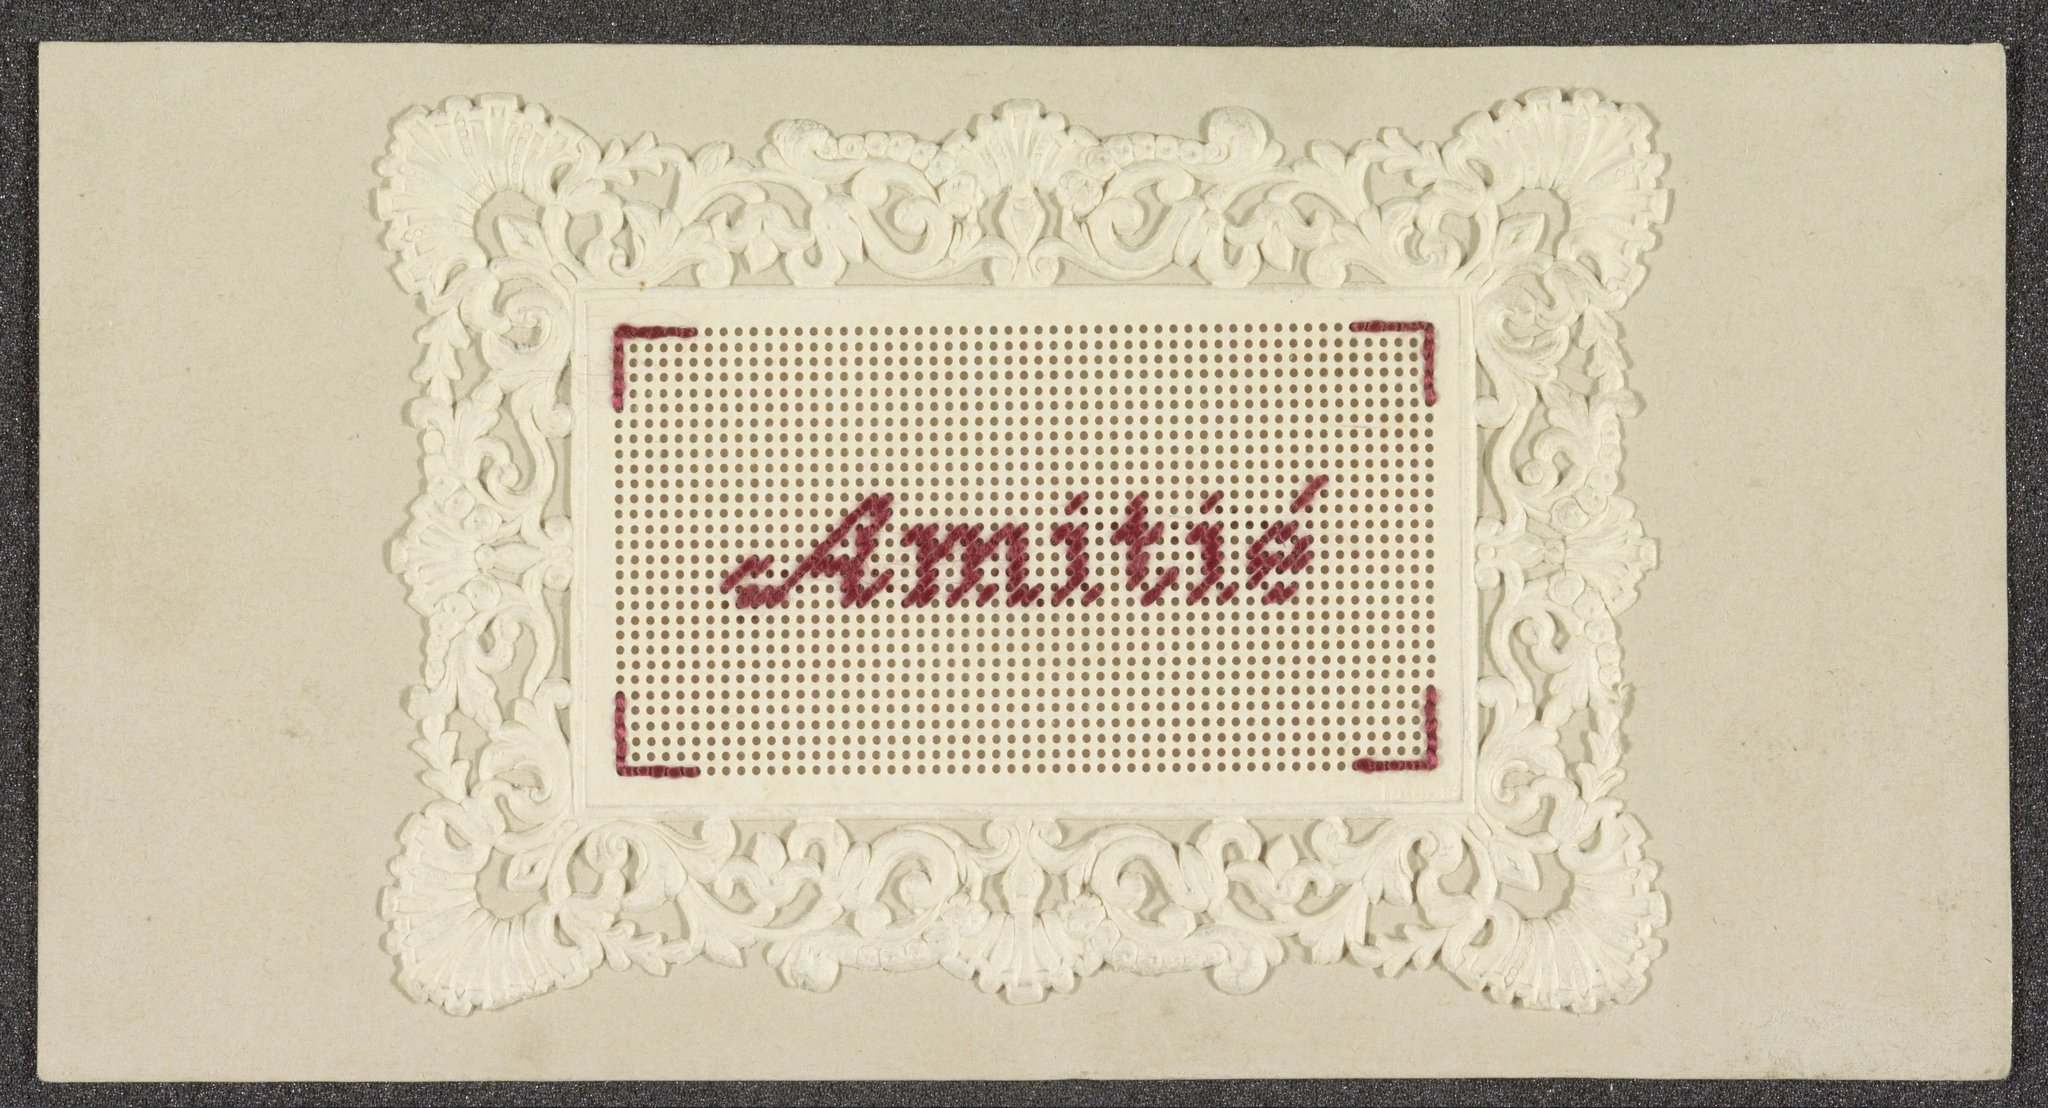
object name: album leaf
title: Geborduurde tekst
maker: h. blyenburg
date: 1848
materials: cardboard, paper, yarns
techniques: embroidered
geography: rotterdam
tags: 'album amicorum', 'stammbuch'